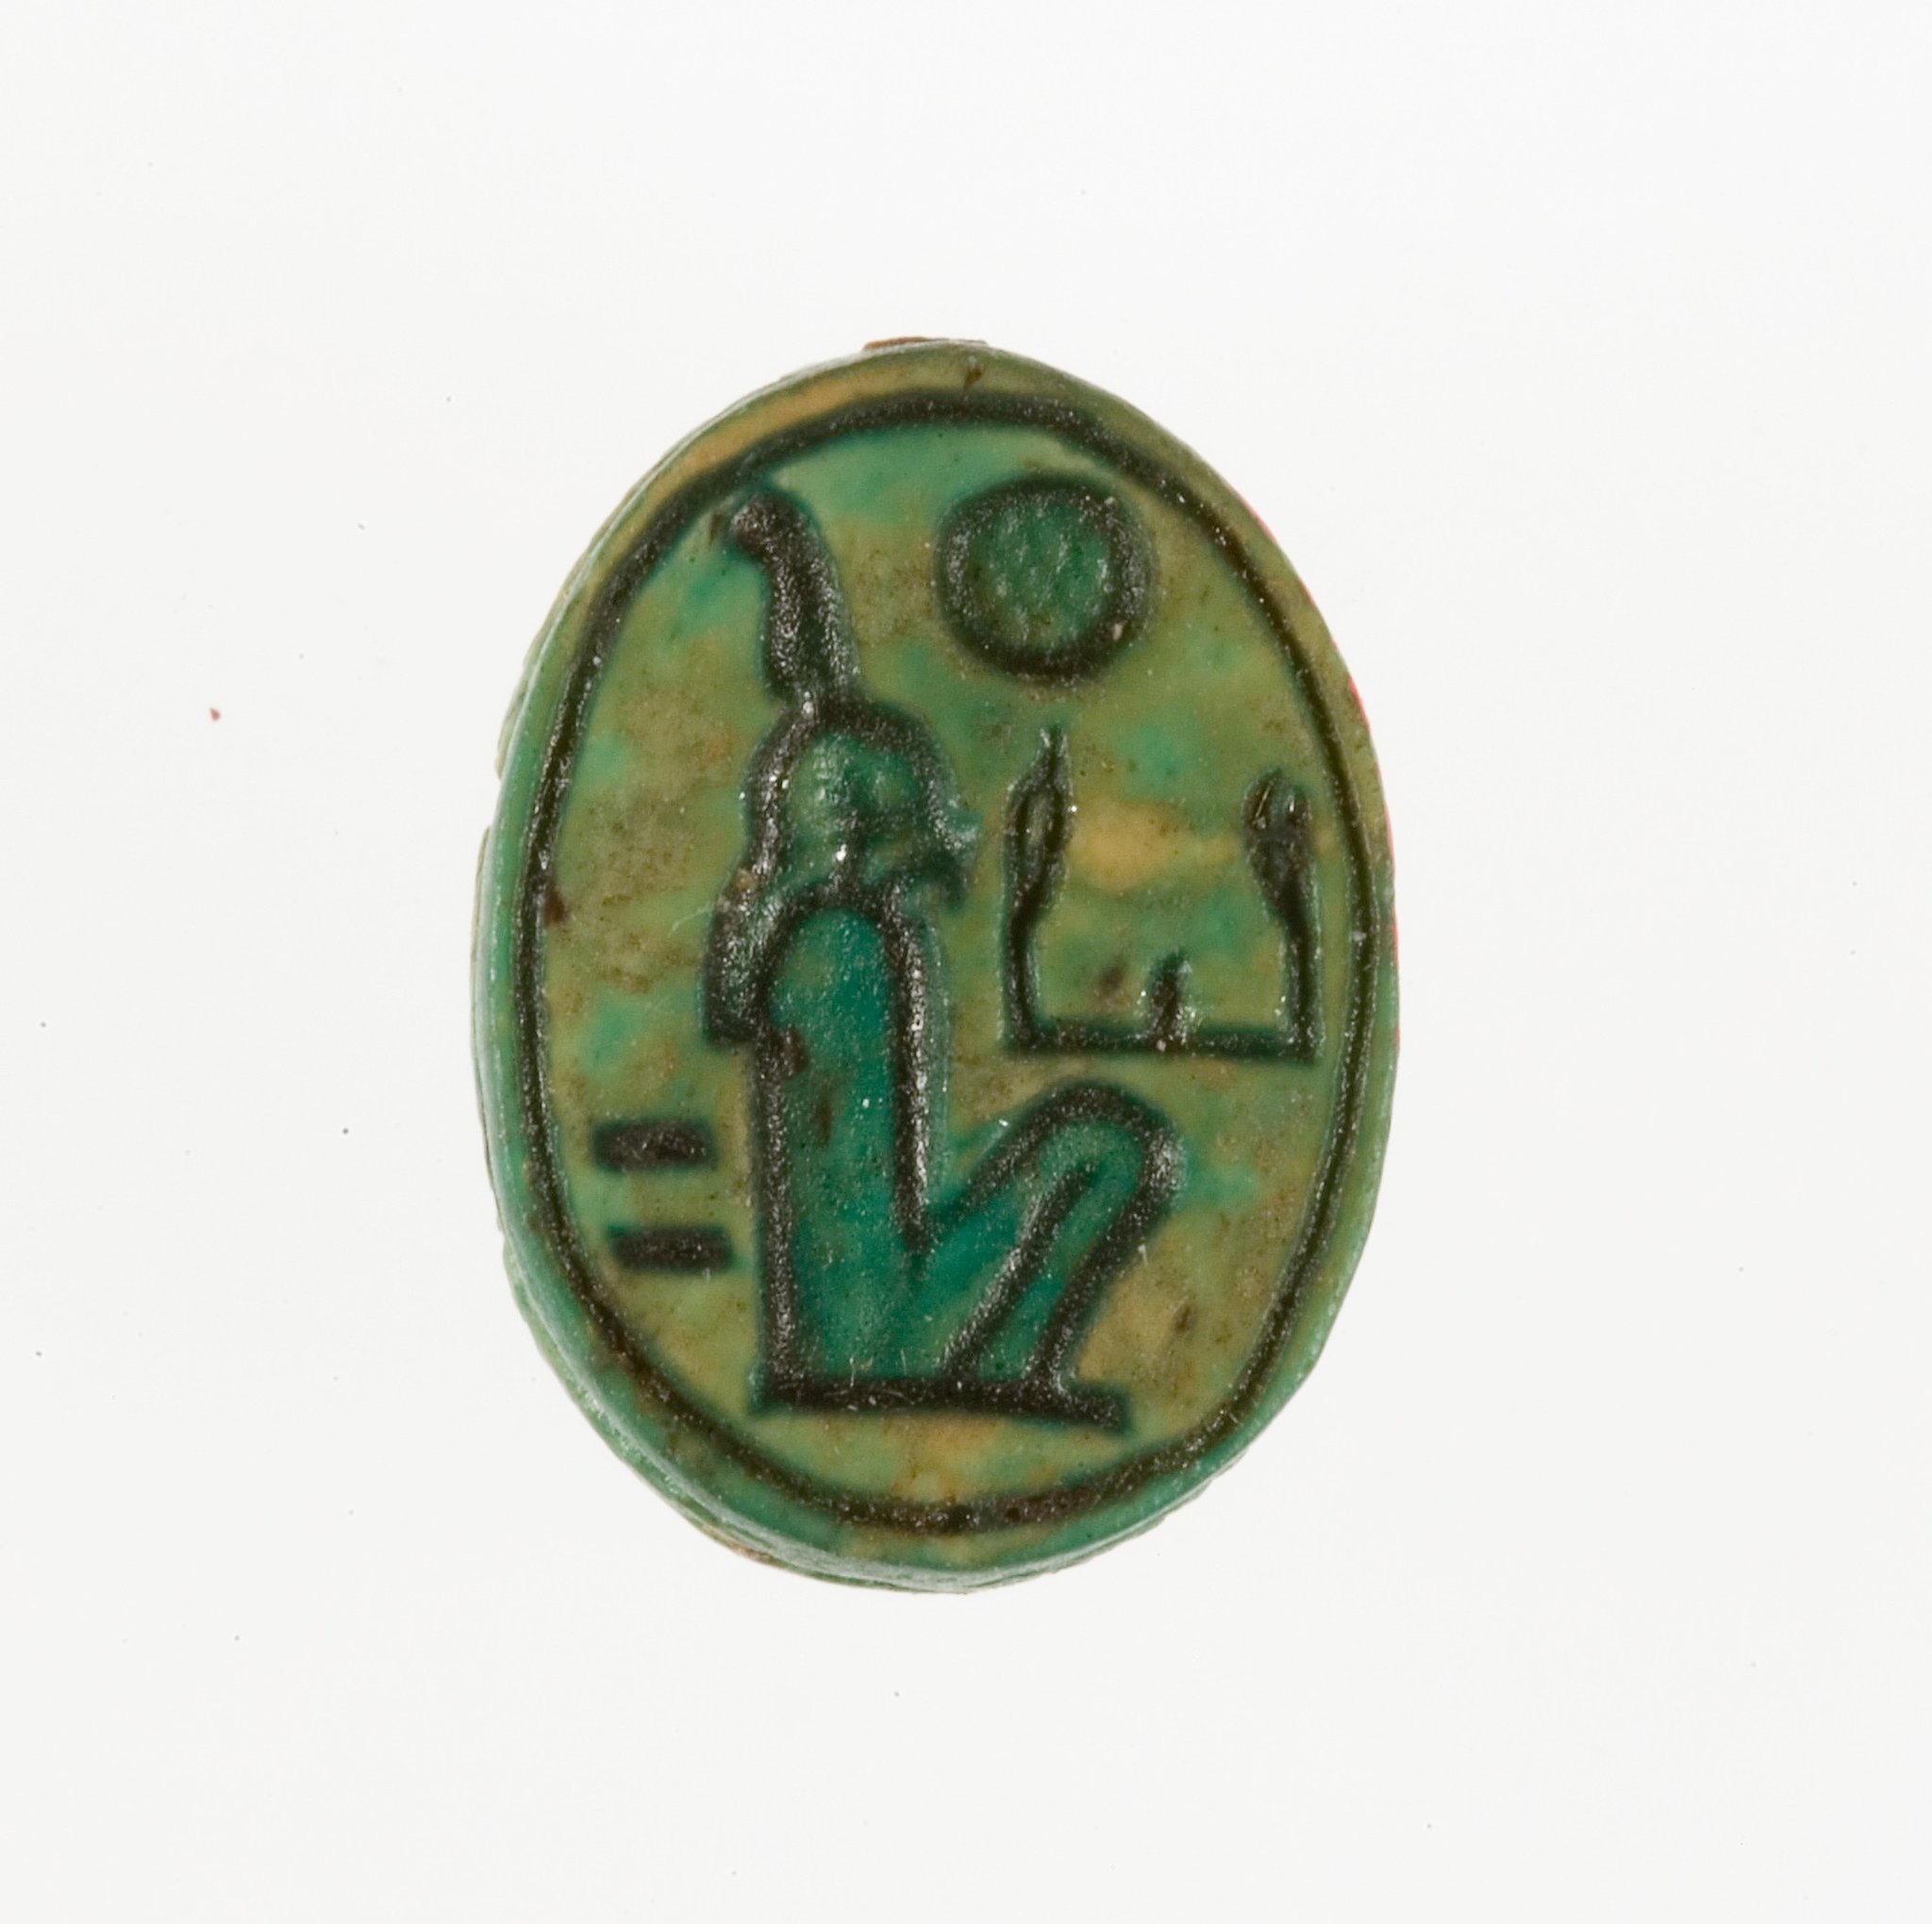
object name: scarab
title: Scarab Inscribed with the Name Maatkare (Hatshepsut)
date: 1479-1458 BCE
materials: stone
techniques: glazing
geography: egypt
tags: human figures,scarabs